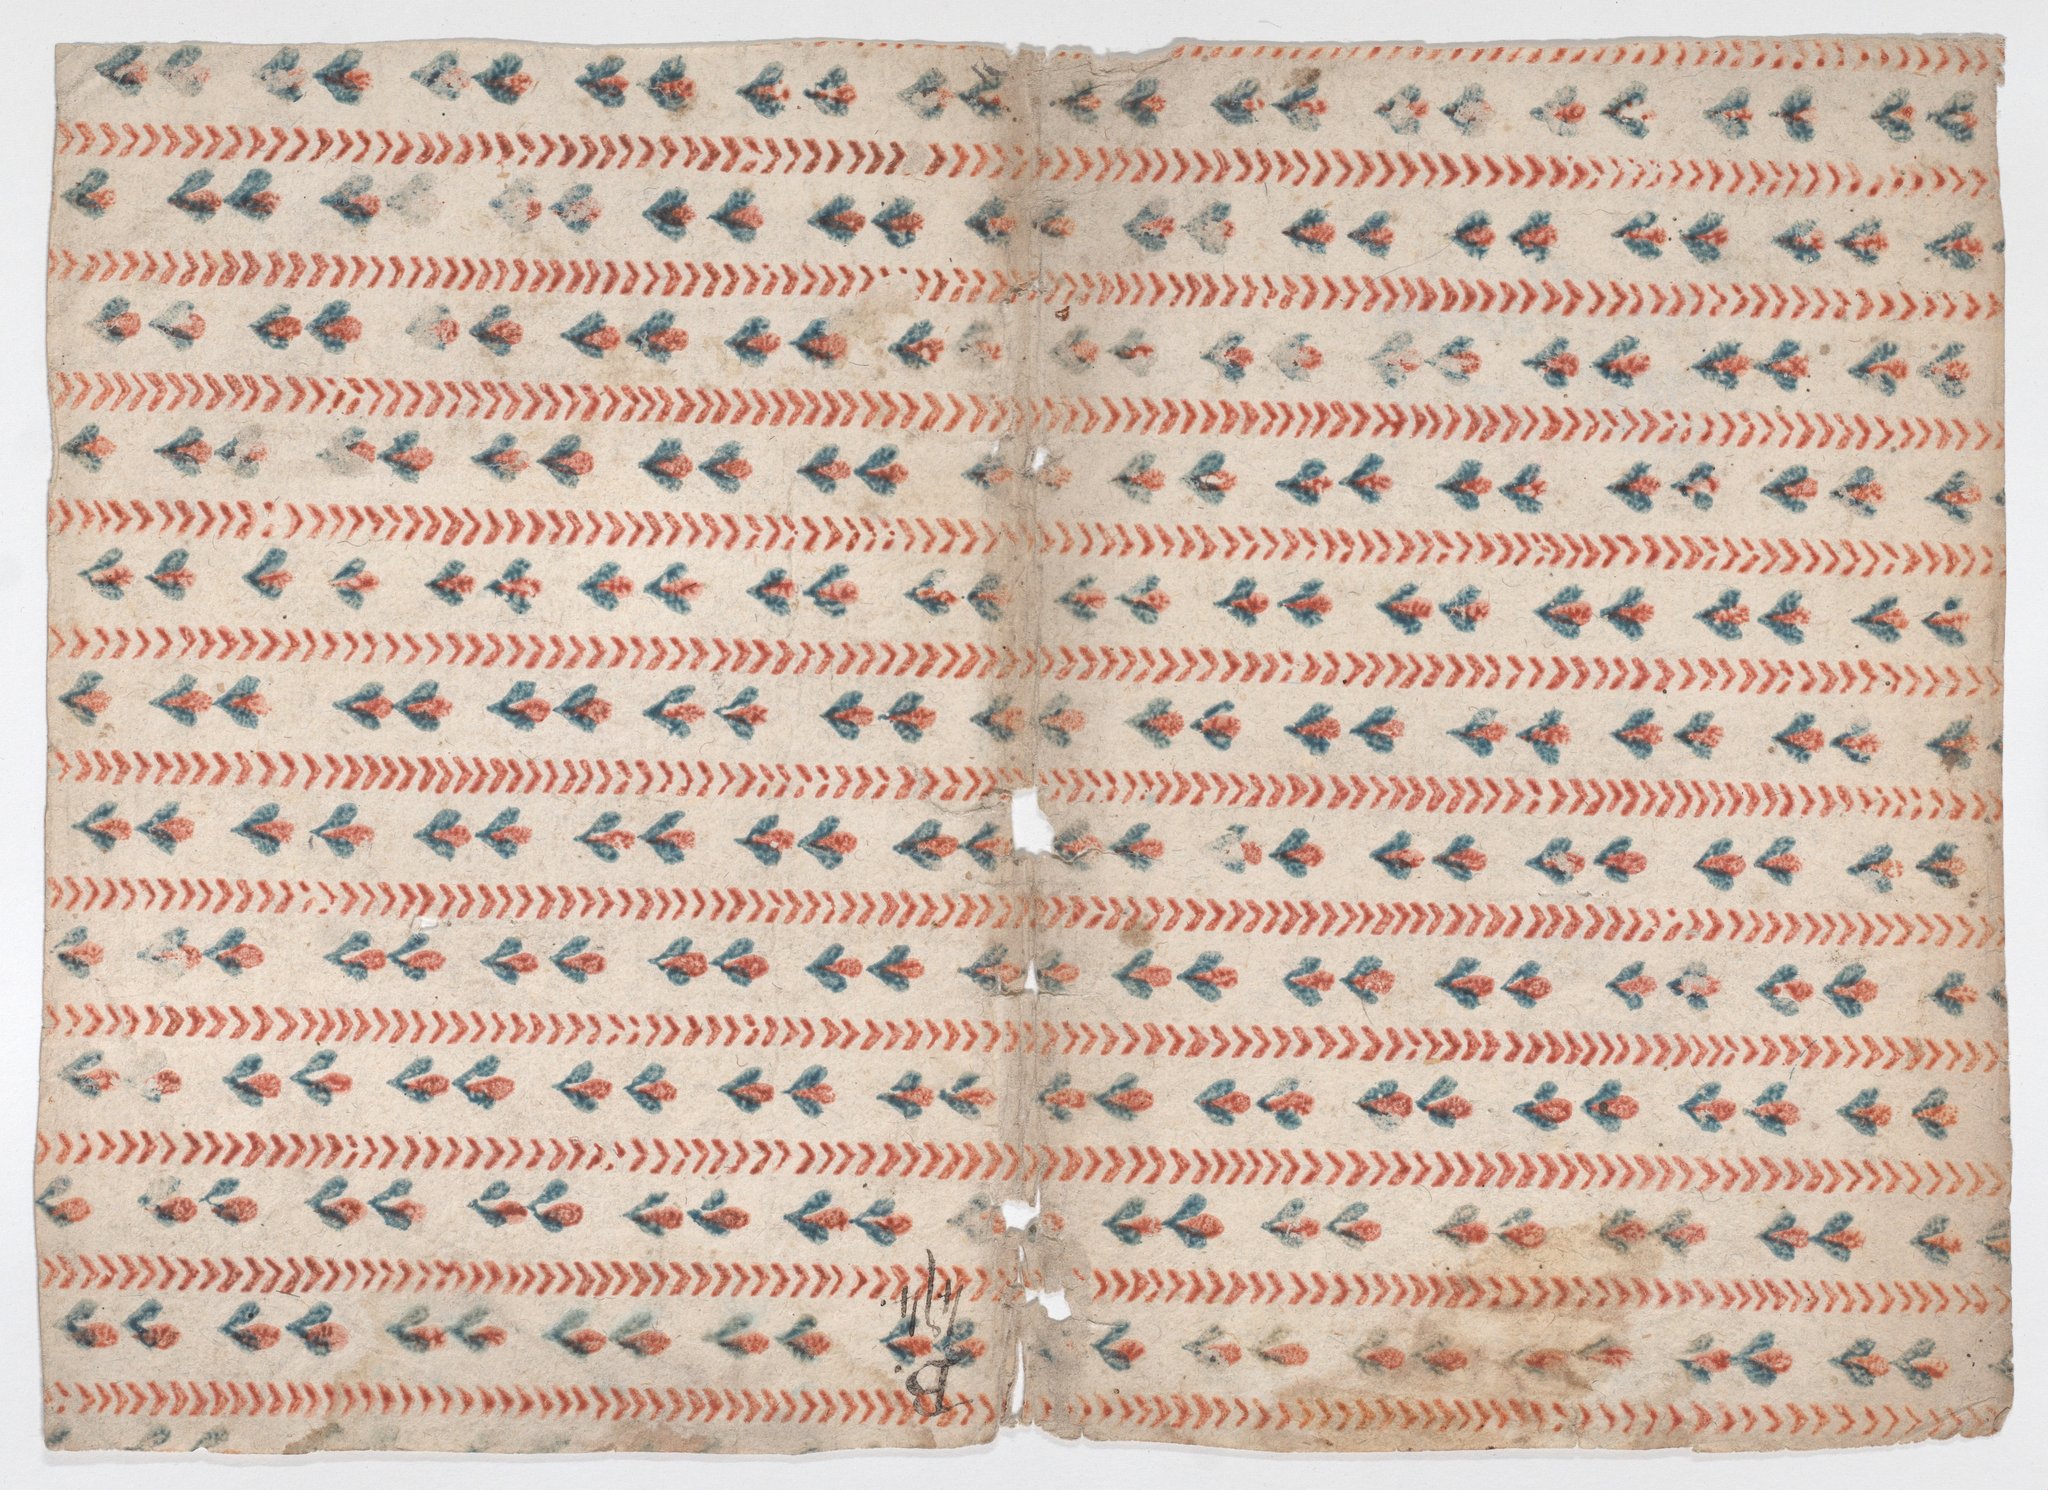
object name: print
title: Book cover with overall floral pattern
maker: Anonymous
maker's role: artist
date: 1801-1900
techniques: relief print